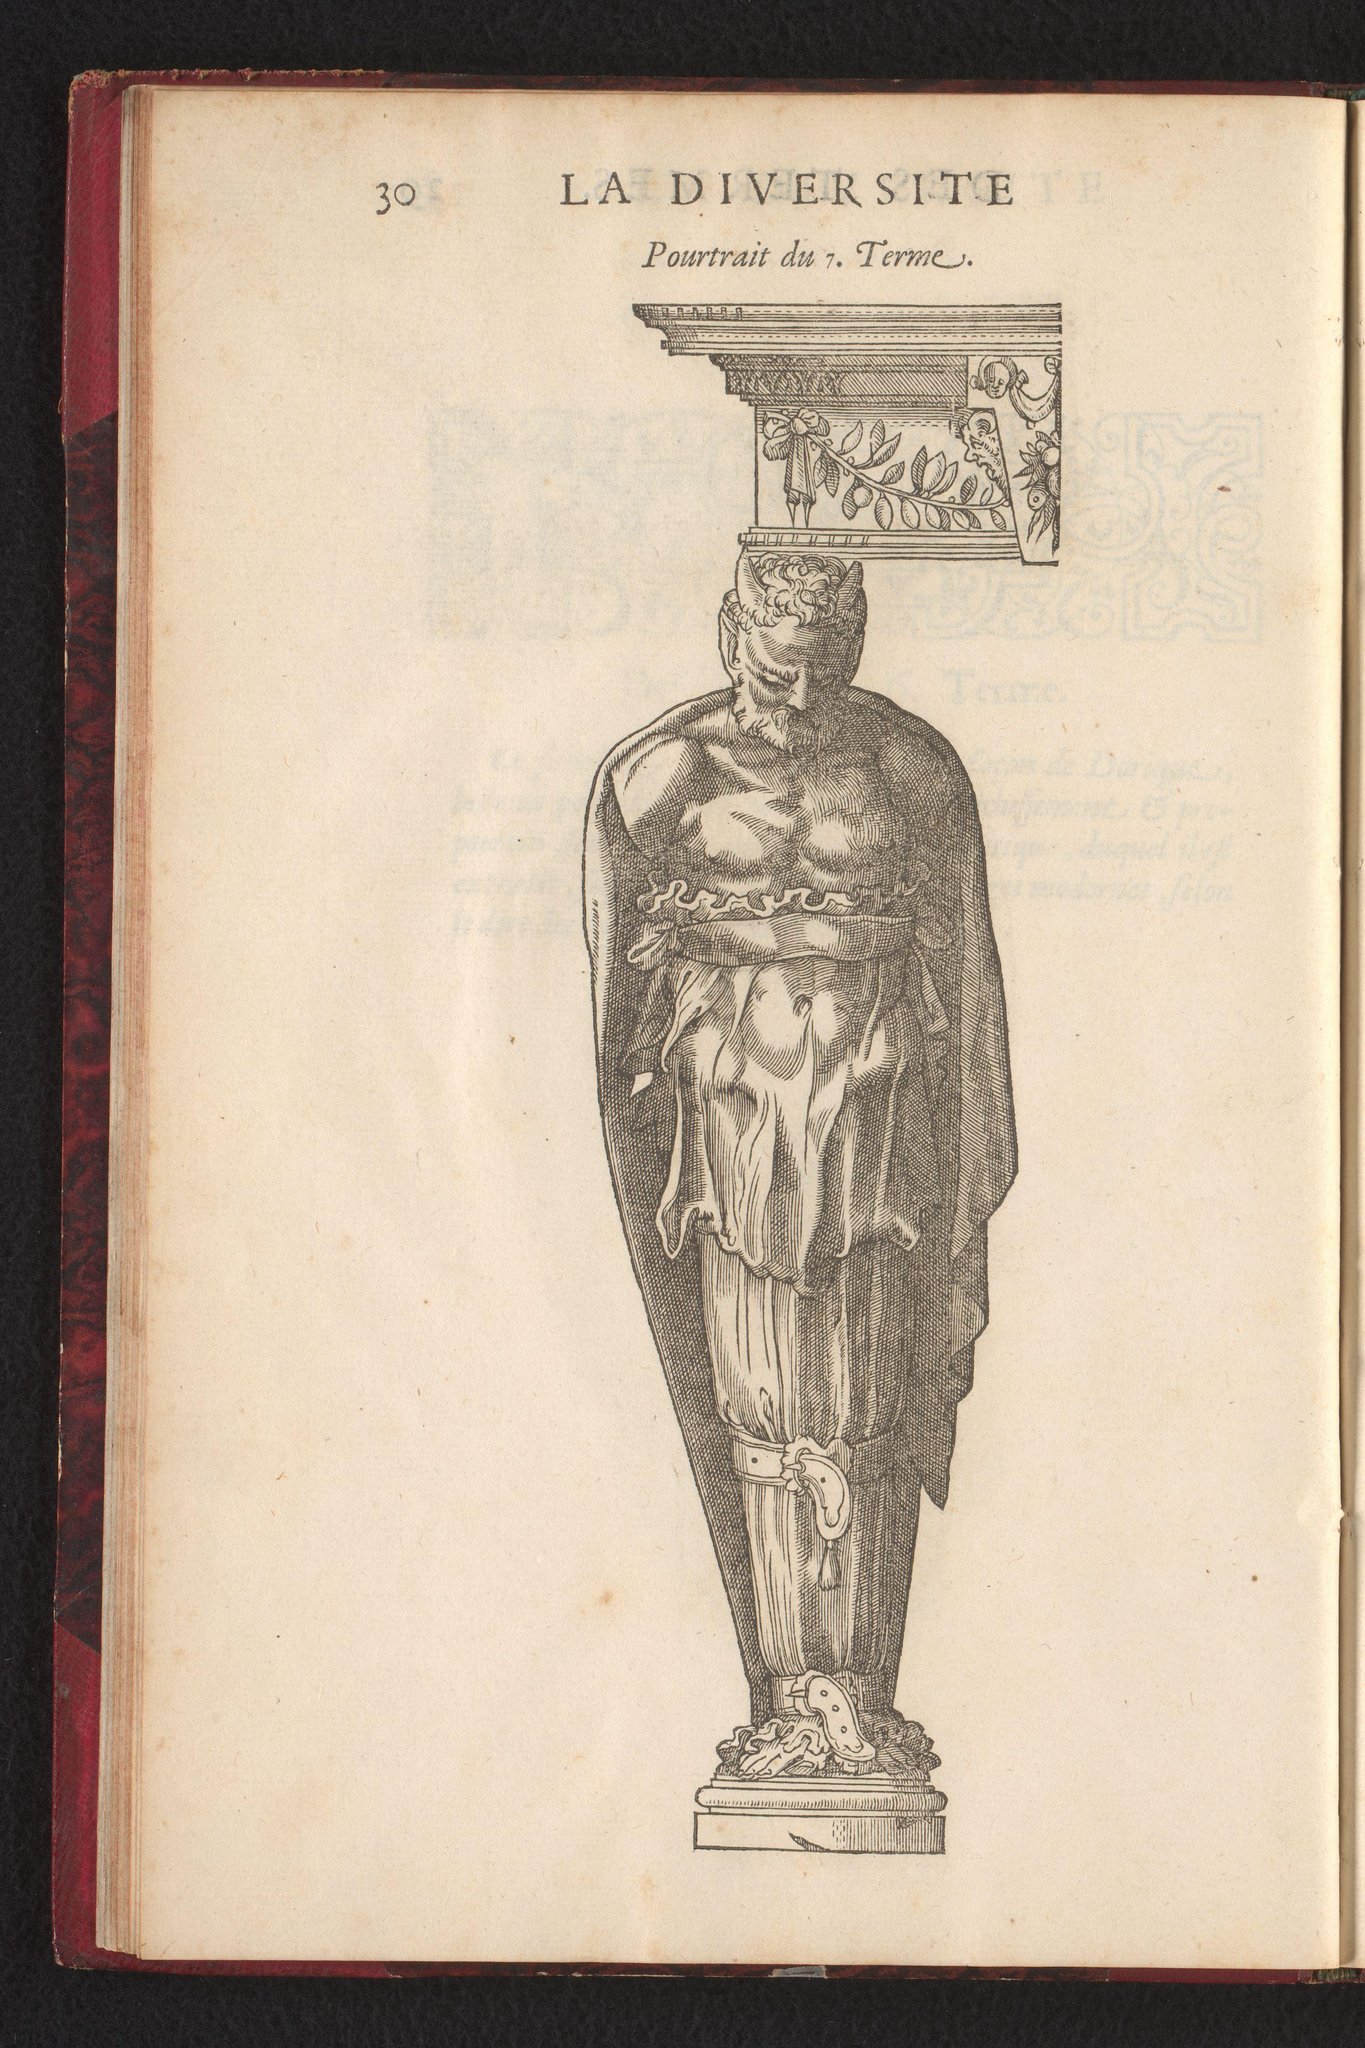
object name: album leaf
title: Oeuvre de la diversité des termes, dont on use en architecture, reduict en ordre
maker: Anonymous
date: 1572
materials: paper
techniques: letterpress printing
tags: herms (garden ornaments), pedestal of a piece of sculpture (perhaps in the form of a herm), satyr(s) (in general), herm: pillar with the head of mercury, patron of travellers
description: Linksboven genummerd: 30. Volgens de toelichting op pagina 32 gaat het hier om de Ionische orde. Prent maakt deel uit van een album.